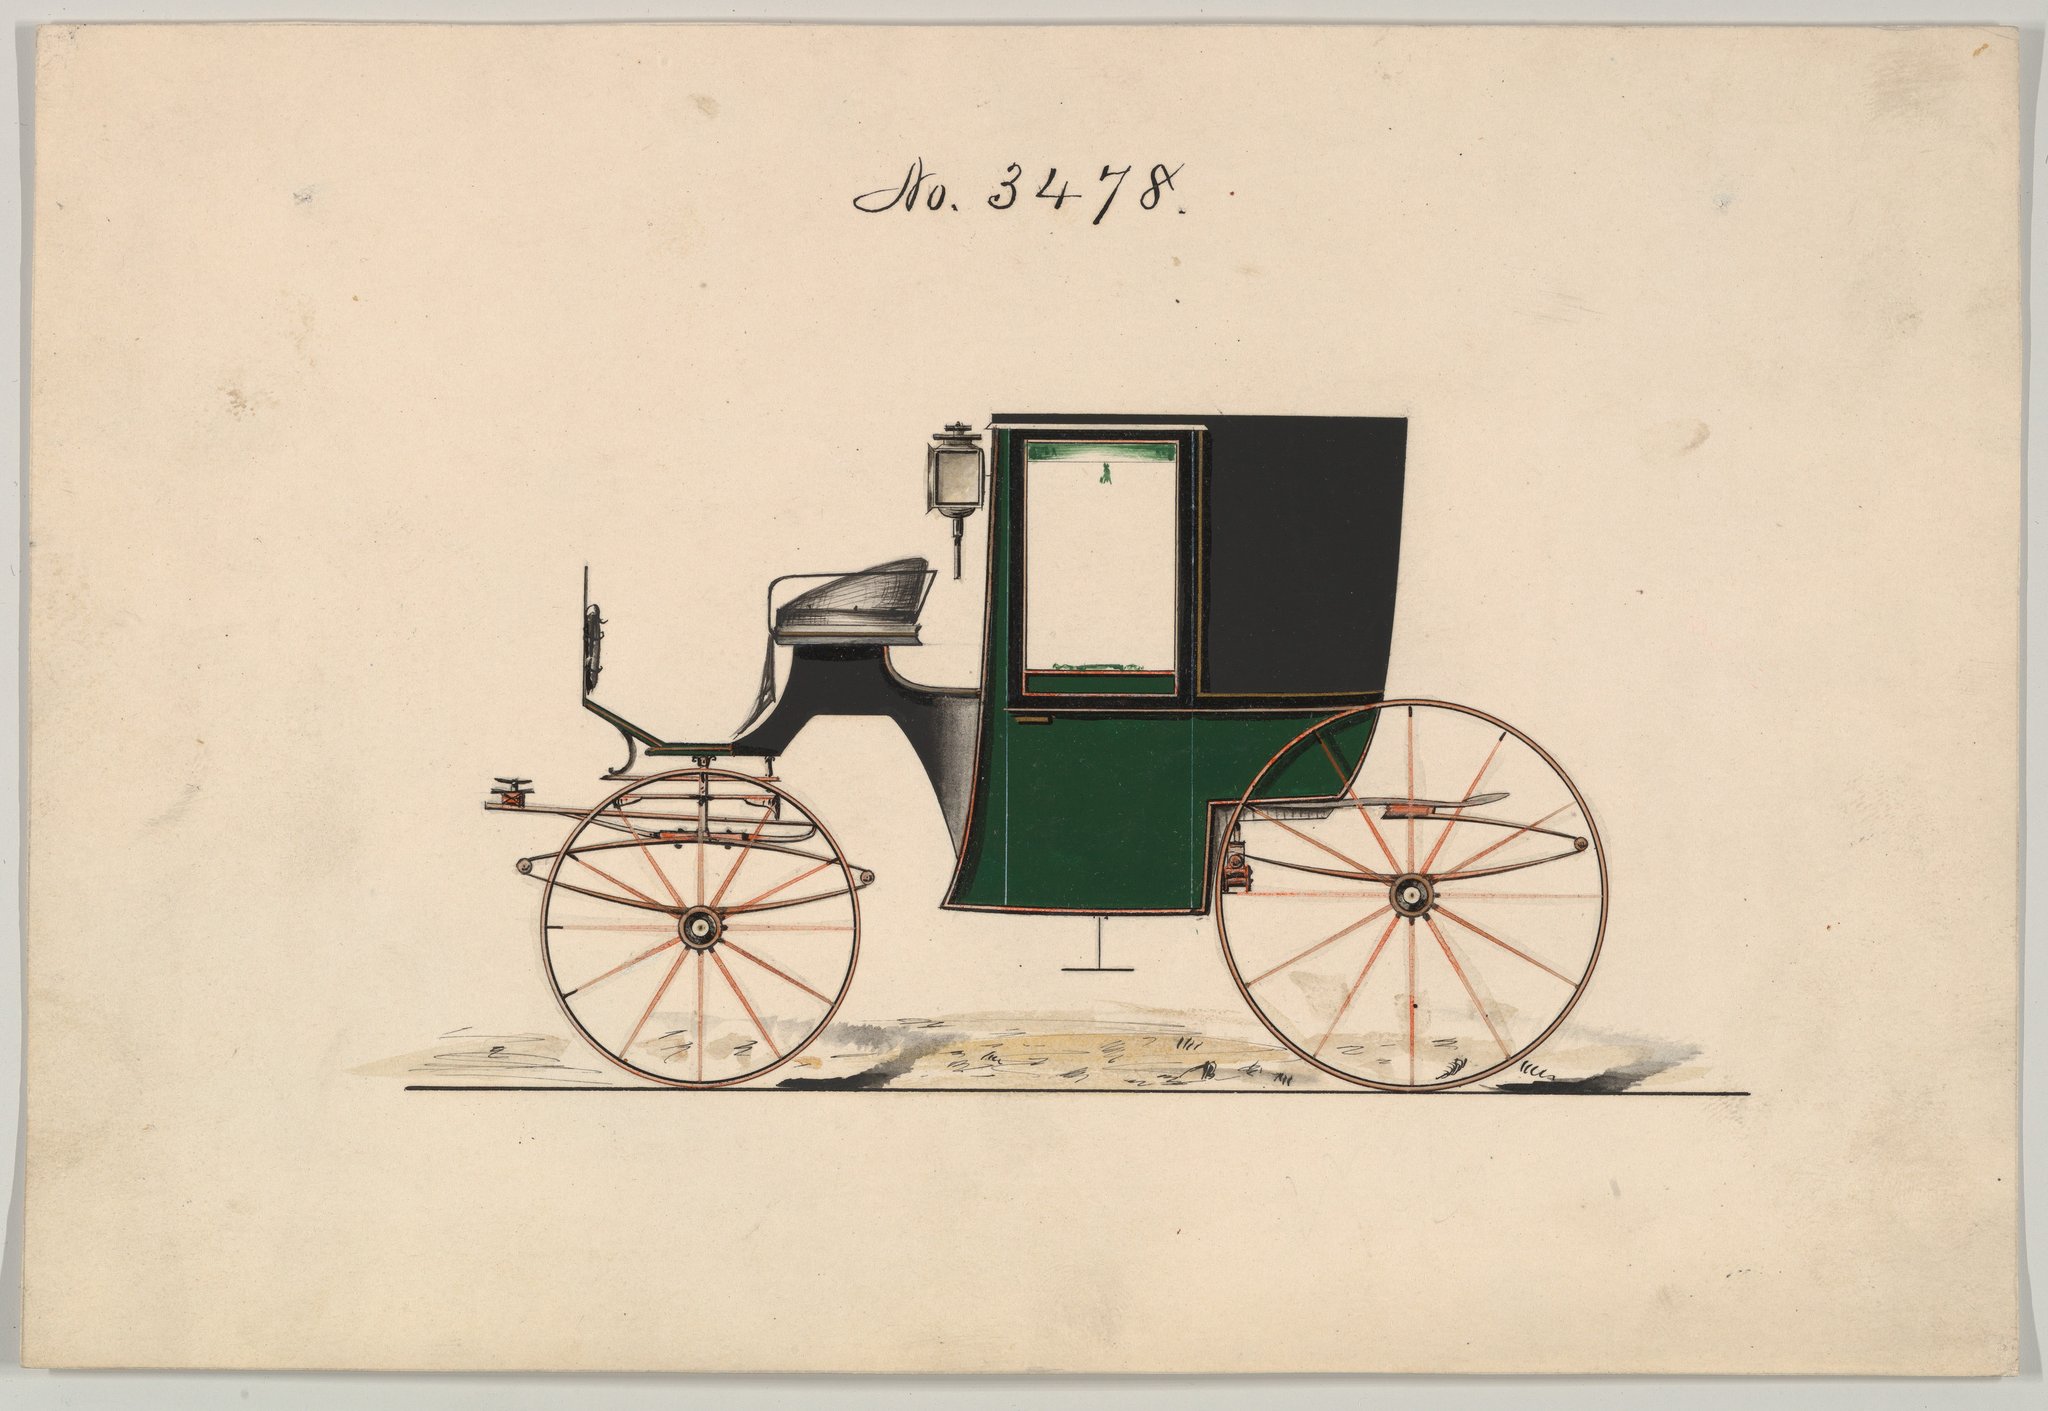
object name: drawing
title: Brougham #3478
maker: brewster & co.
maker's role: manufacturer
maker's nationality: american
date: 1878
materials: gouache, gum arabic, ink, watercolor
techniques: pen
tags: carriages